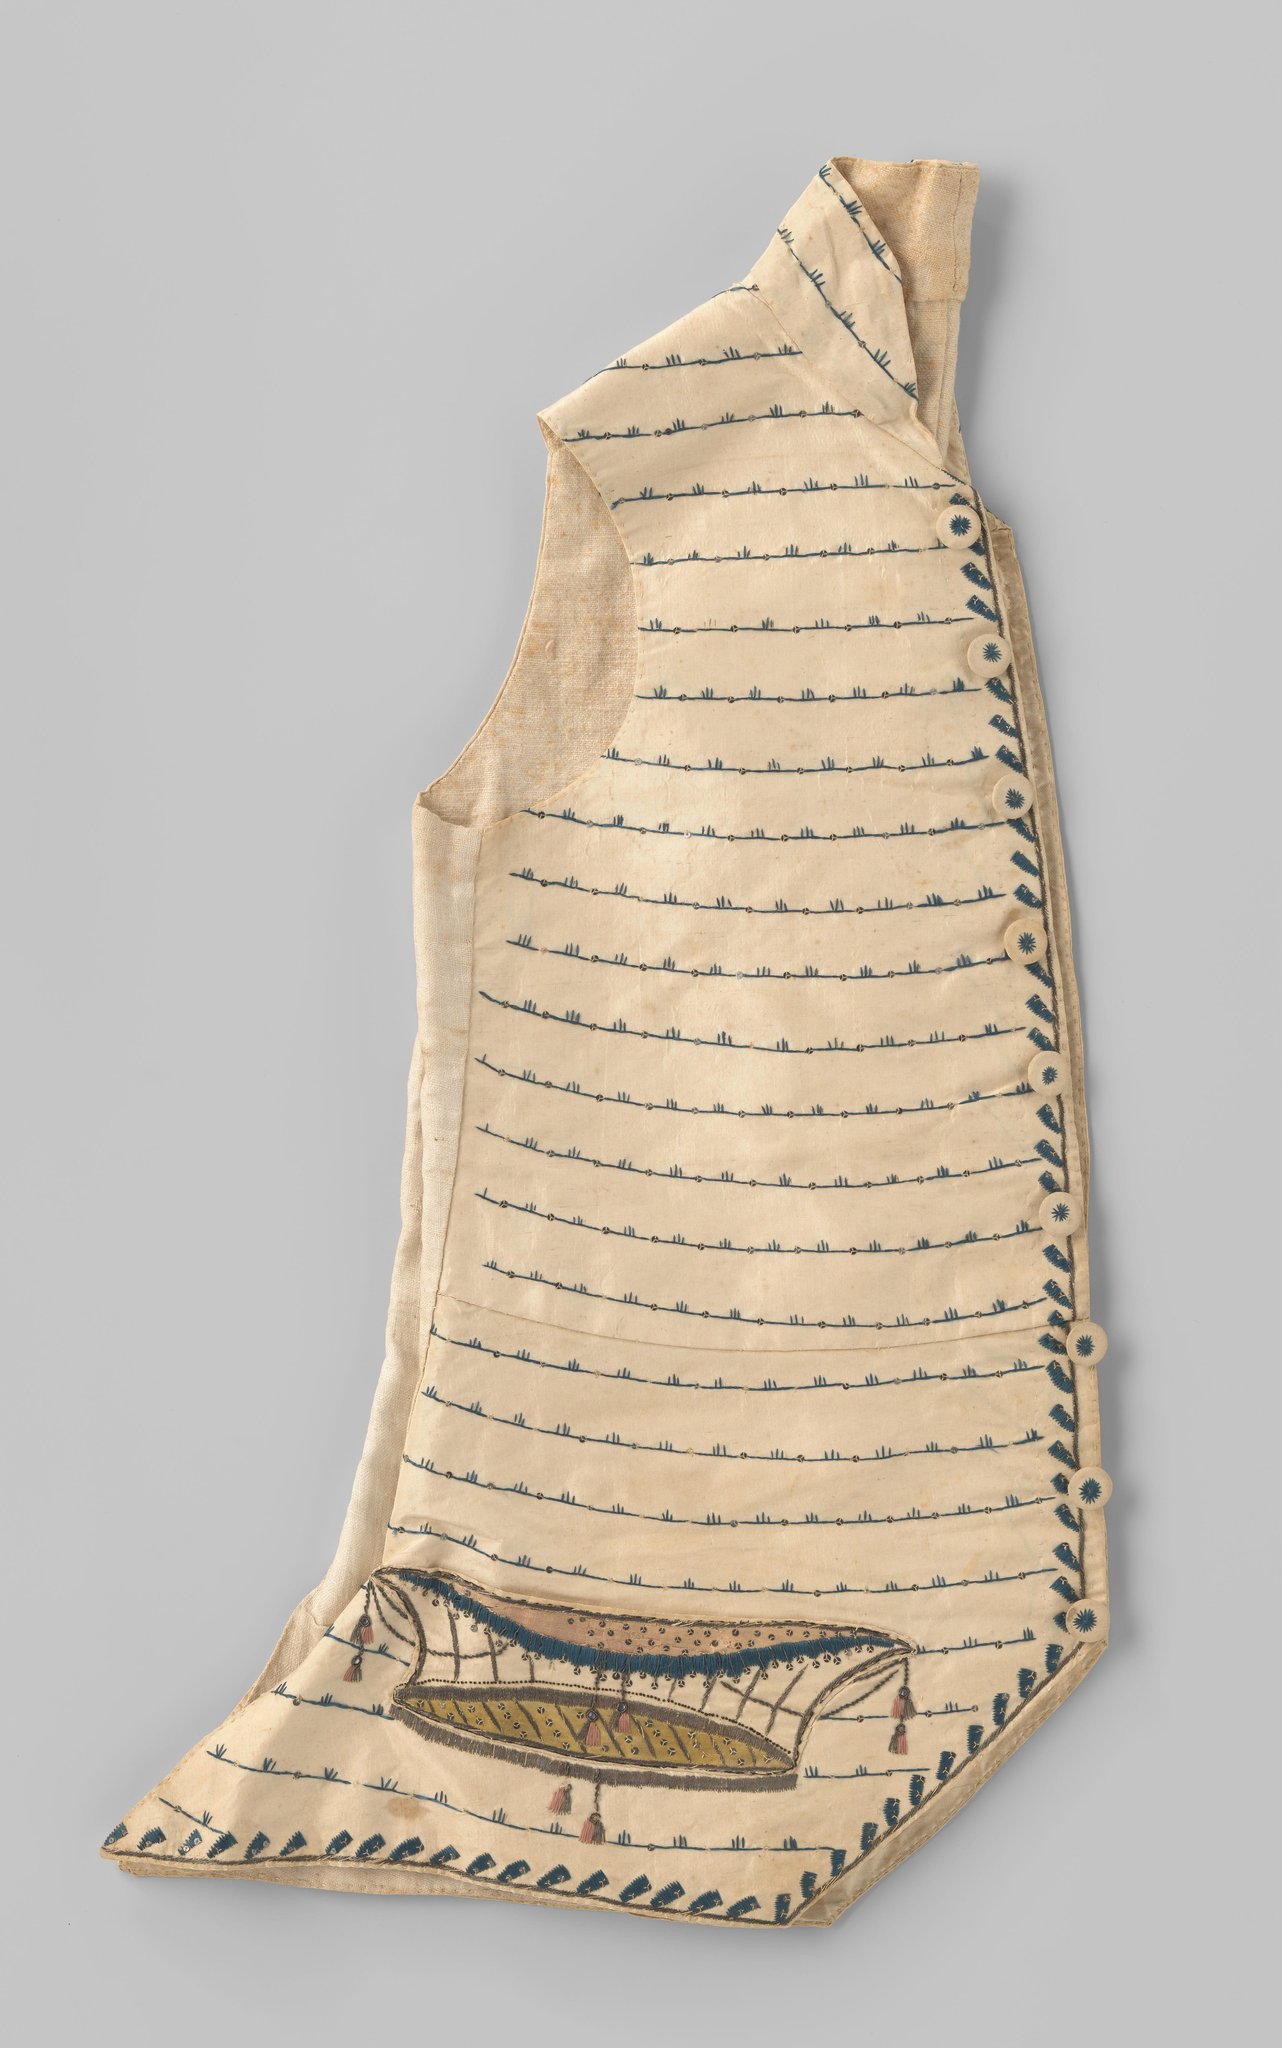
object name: vest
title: Vest van crème ripszijde met blauwe lijnen met pailletten en twee nepzakken, gevormd door een geborduurd "feestmuts"-motief met pailletten, zilverdraad en blauwe stenen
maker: Anonymous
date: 1795-1805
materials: glass, linen, sequin, silk, thread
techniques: rib binding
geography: netherlands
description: Herenvest van crèmekleurige zijde geborduurd met blauwe en rose zijde, zilverdraad, zilveren pailletten en geslepen glazen steentjes. Opstaand boord, sluiting door middel van 9 knopen.